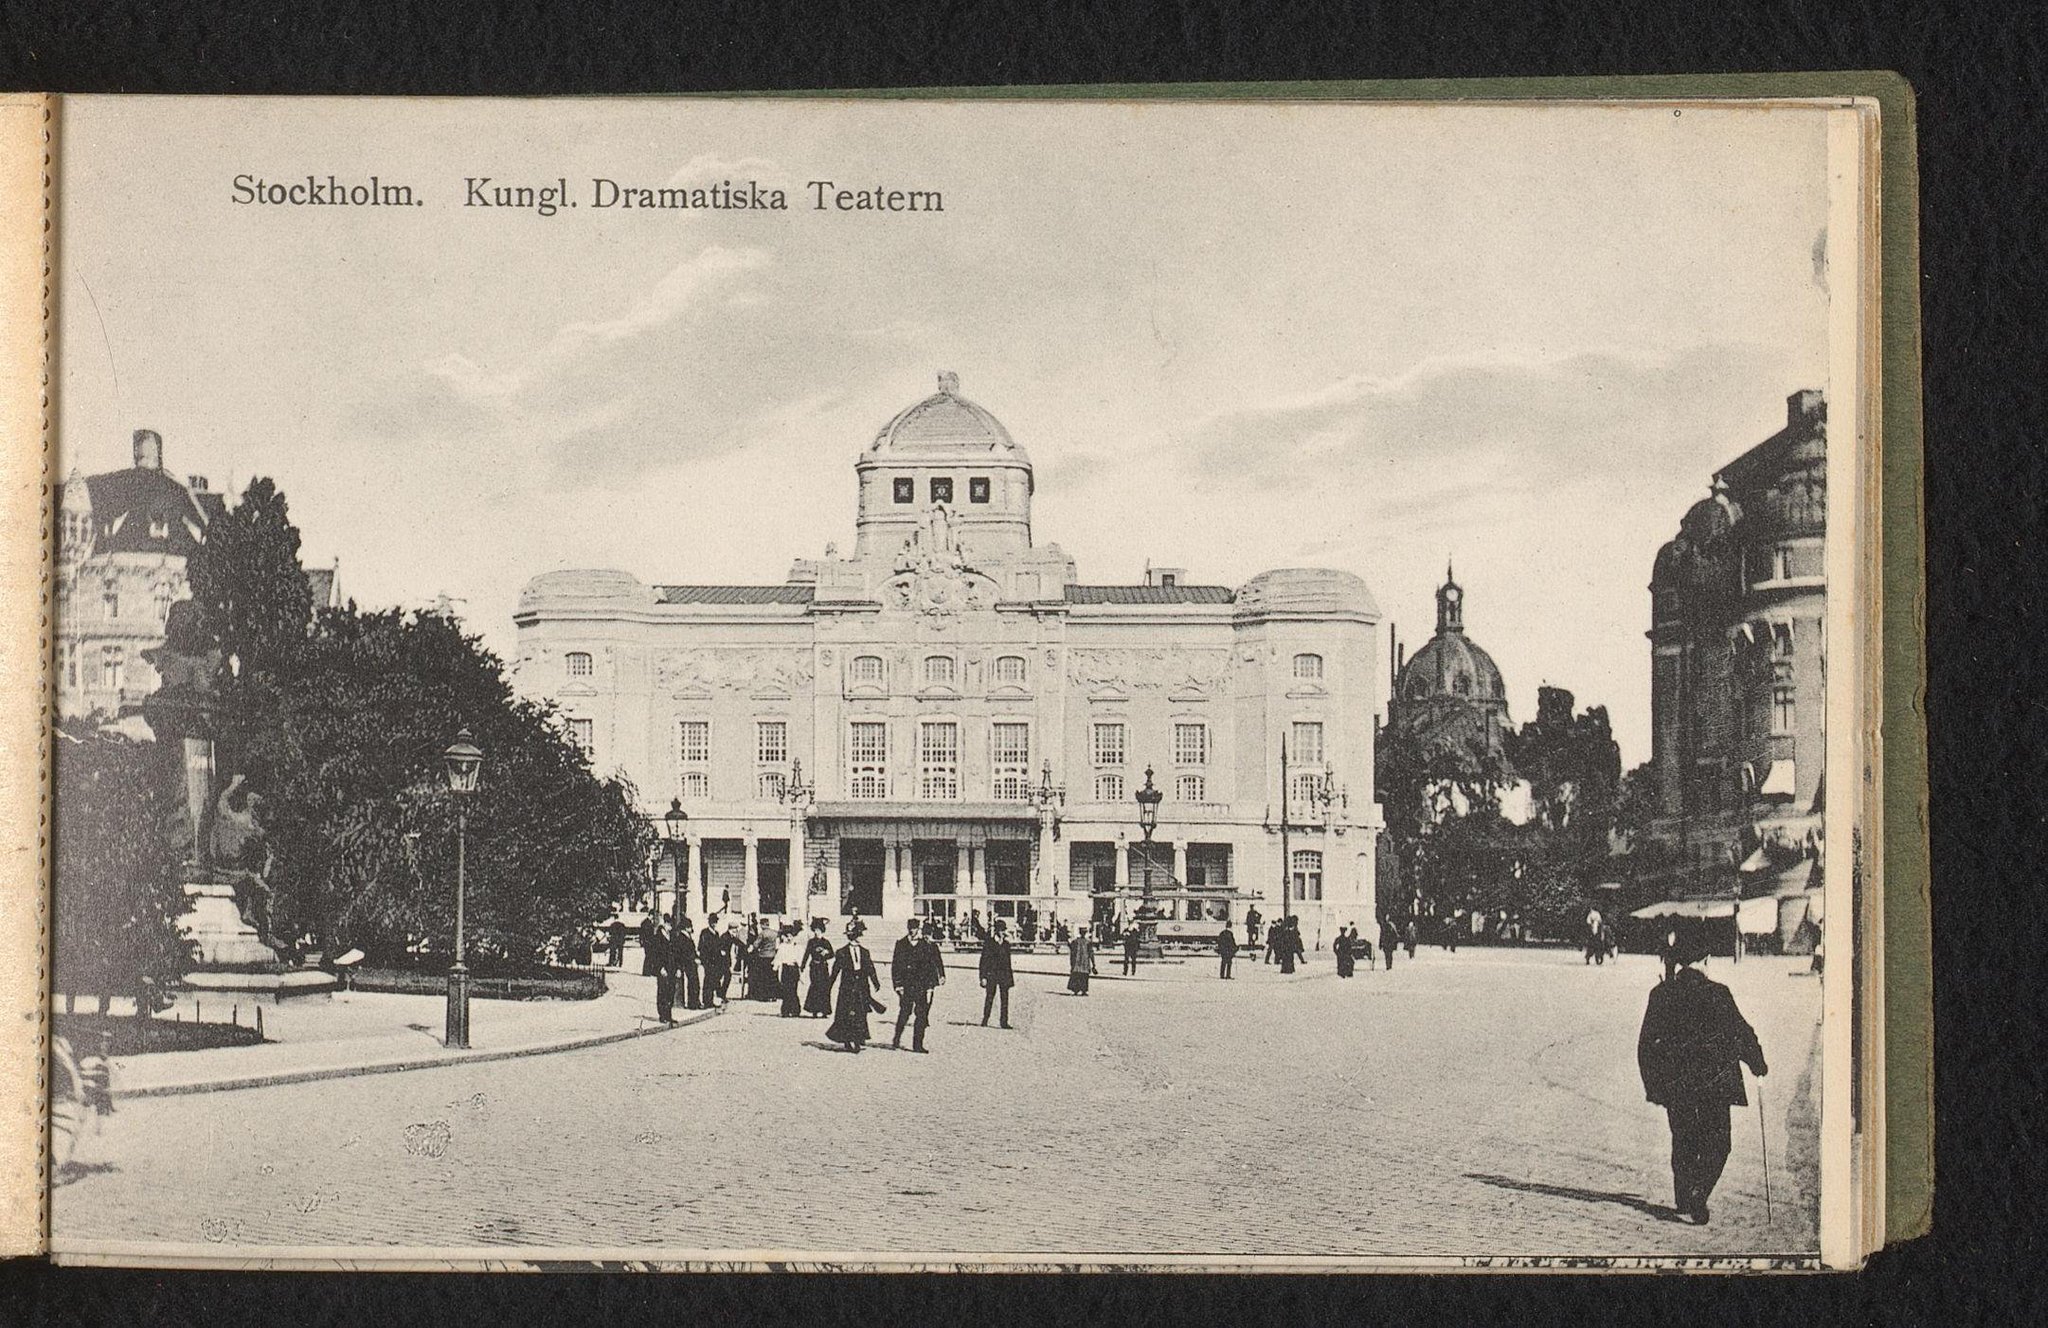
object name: ansichtkaart, prentbriefkaart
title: Stockholm. Kungl. Dramatiska Teatern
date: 1905-1930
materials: cardboard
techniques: photograph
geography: stockholm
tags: theatre (building)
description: Prentbriefkaart maakt deel uit van een album.